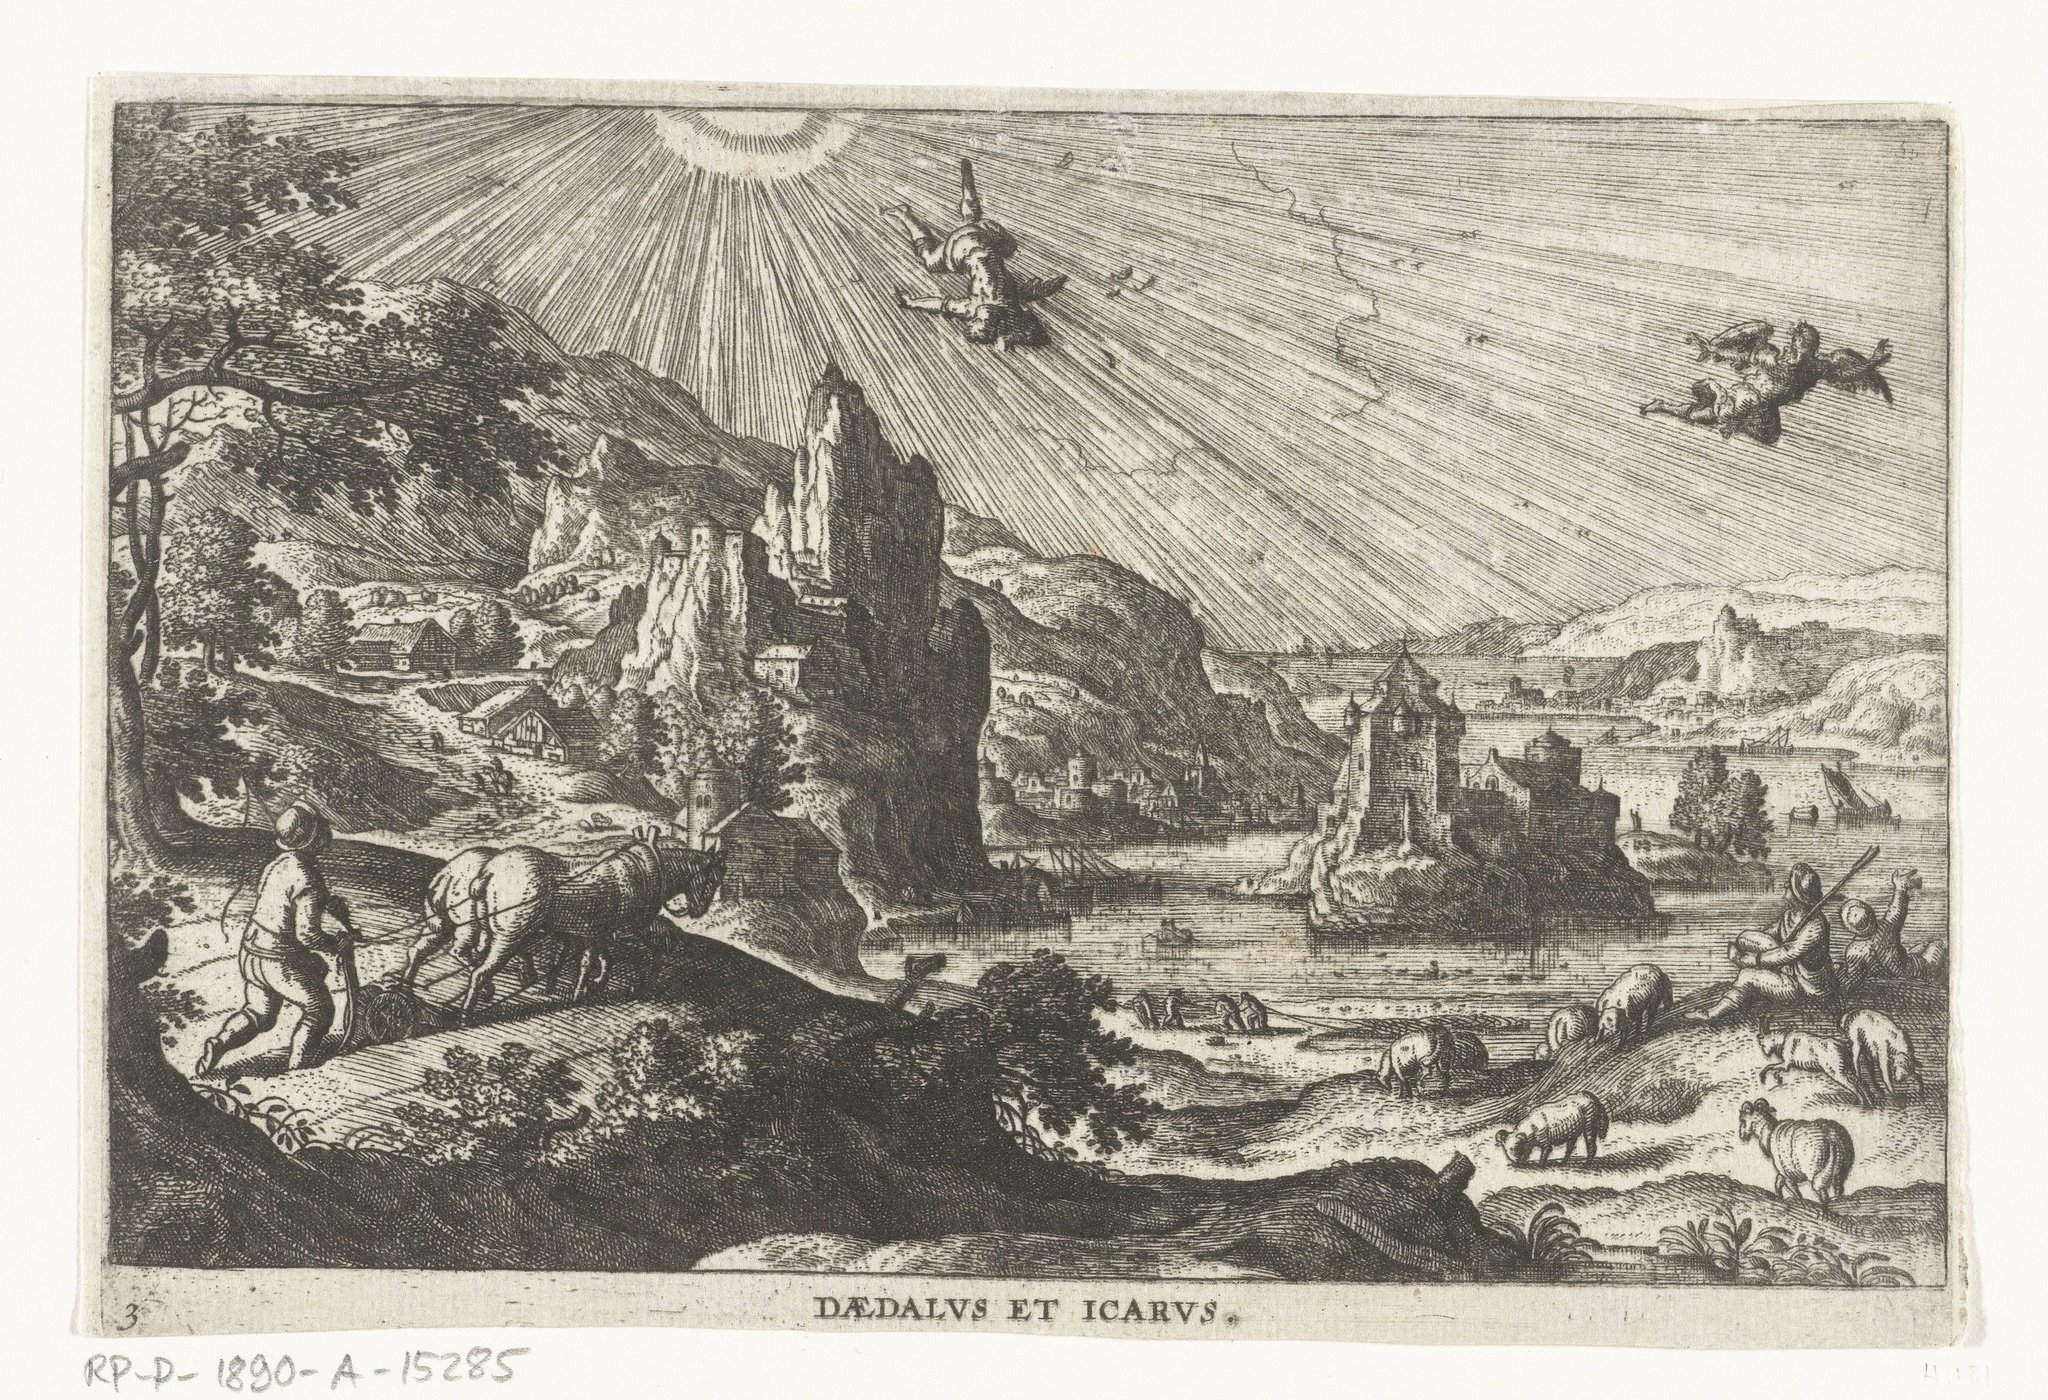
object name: print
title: Landschappen met mythologische en bijbelse voorstellingen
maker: Anonymous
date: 1550-1650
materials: paper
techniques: etching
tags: the flight of daedalus and icarus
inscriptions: collector's mark: Lugt 2228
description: Icarus valt halsoverkop uit de lucht, zijn vader Daedalus vliegt een stukje verderop en ziet het ongeluk gebeuren. Op het land kijken boeren en herders omhoog naar de vallende Icarus.